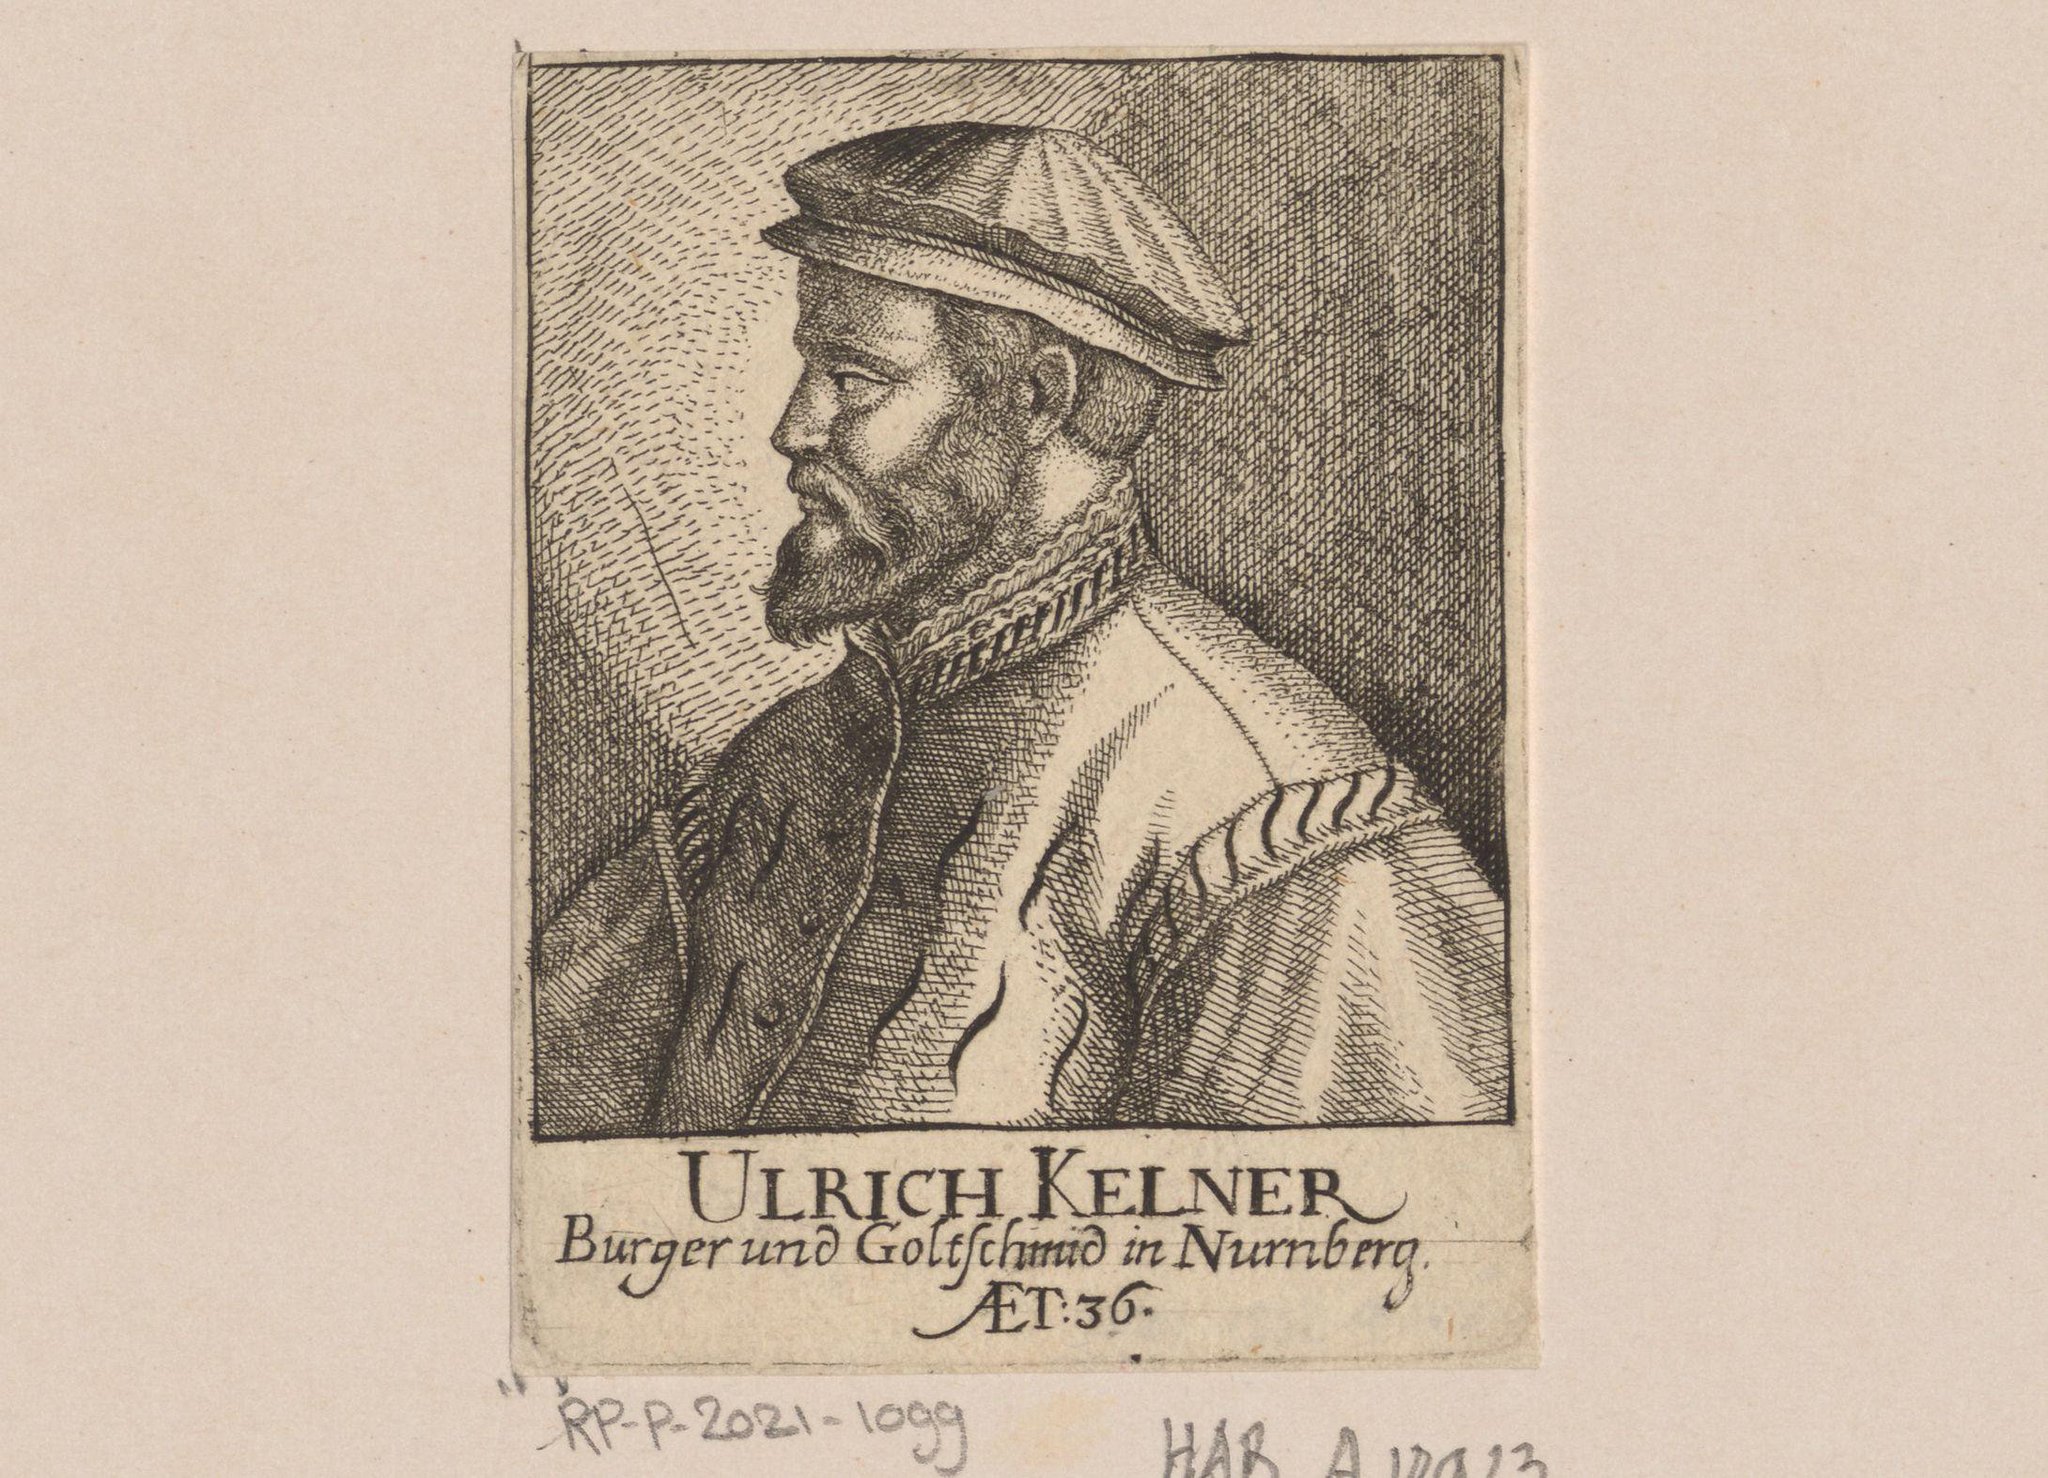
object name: print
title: Portret van Ulrich Kelner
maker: Anonymous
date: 1600-1699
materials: paper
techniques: etching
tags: drawing, historical persons